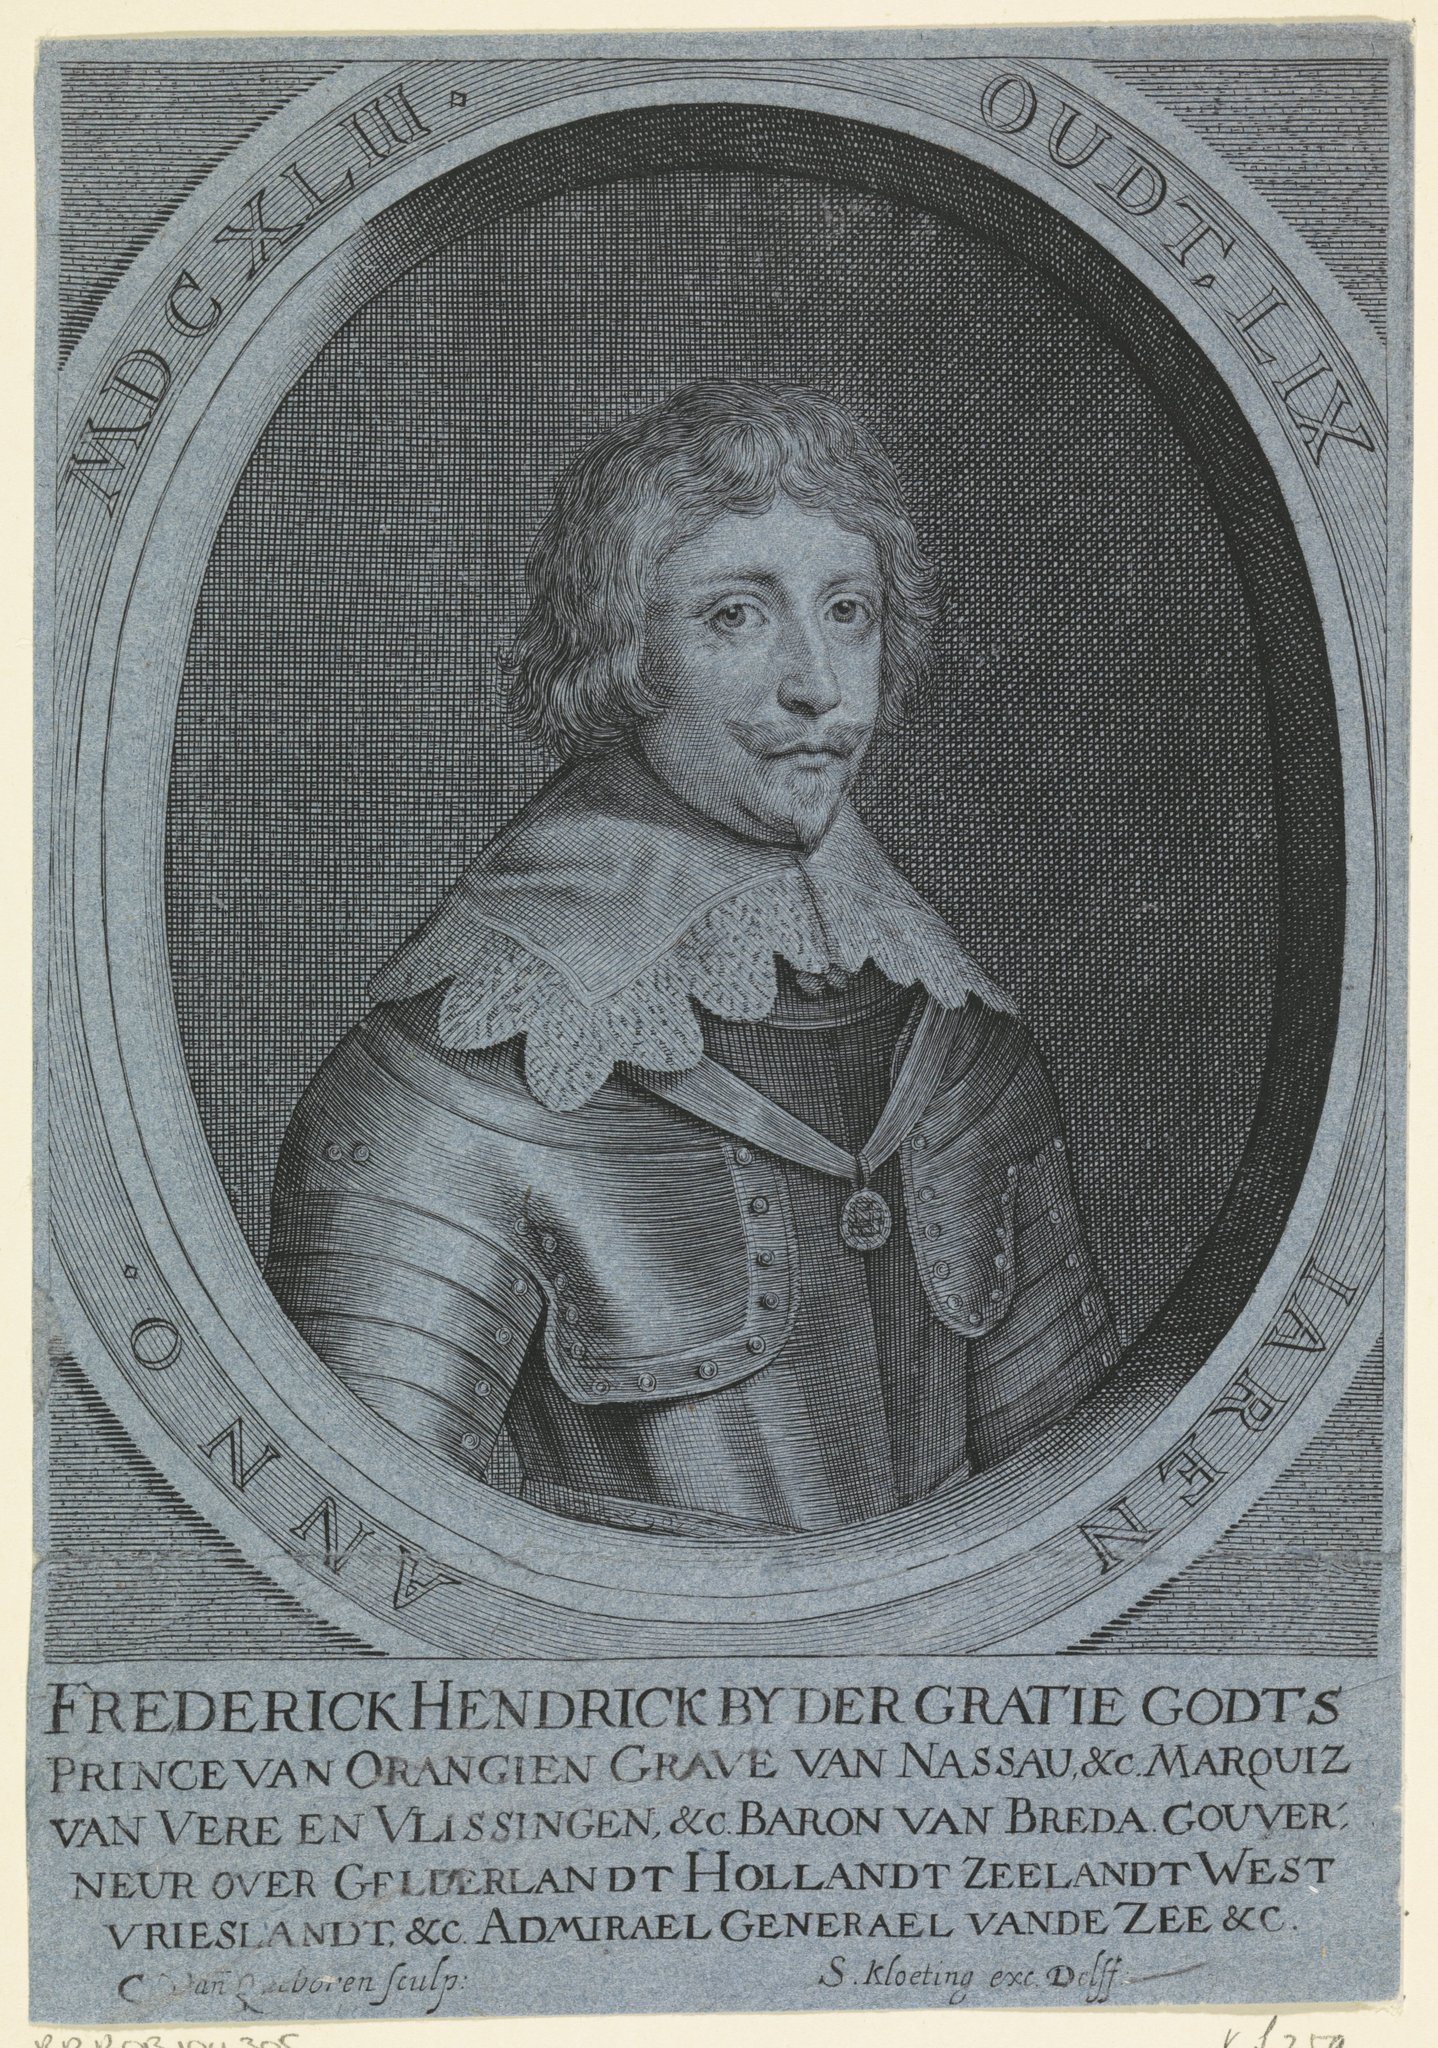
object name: print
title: Portret van Frederik Hendrik, prins van Oranje, op 59-jarige leeftijd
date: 1643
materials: paper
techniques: engraving, etching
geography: delft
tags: delft, the hague, frederick henry (prince of orange), knighthood order (garter) - insignia of a knighthood order, e.g.: badge, chain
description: De hier vermelde titel verwijst naar de hoogst verkregen titel van de geportretteerde, niet per se naar de titel die de geportretteerde op deze voorstelling draagt.